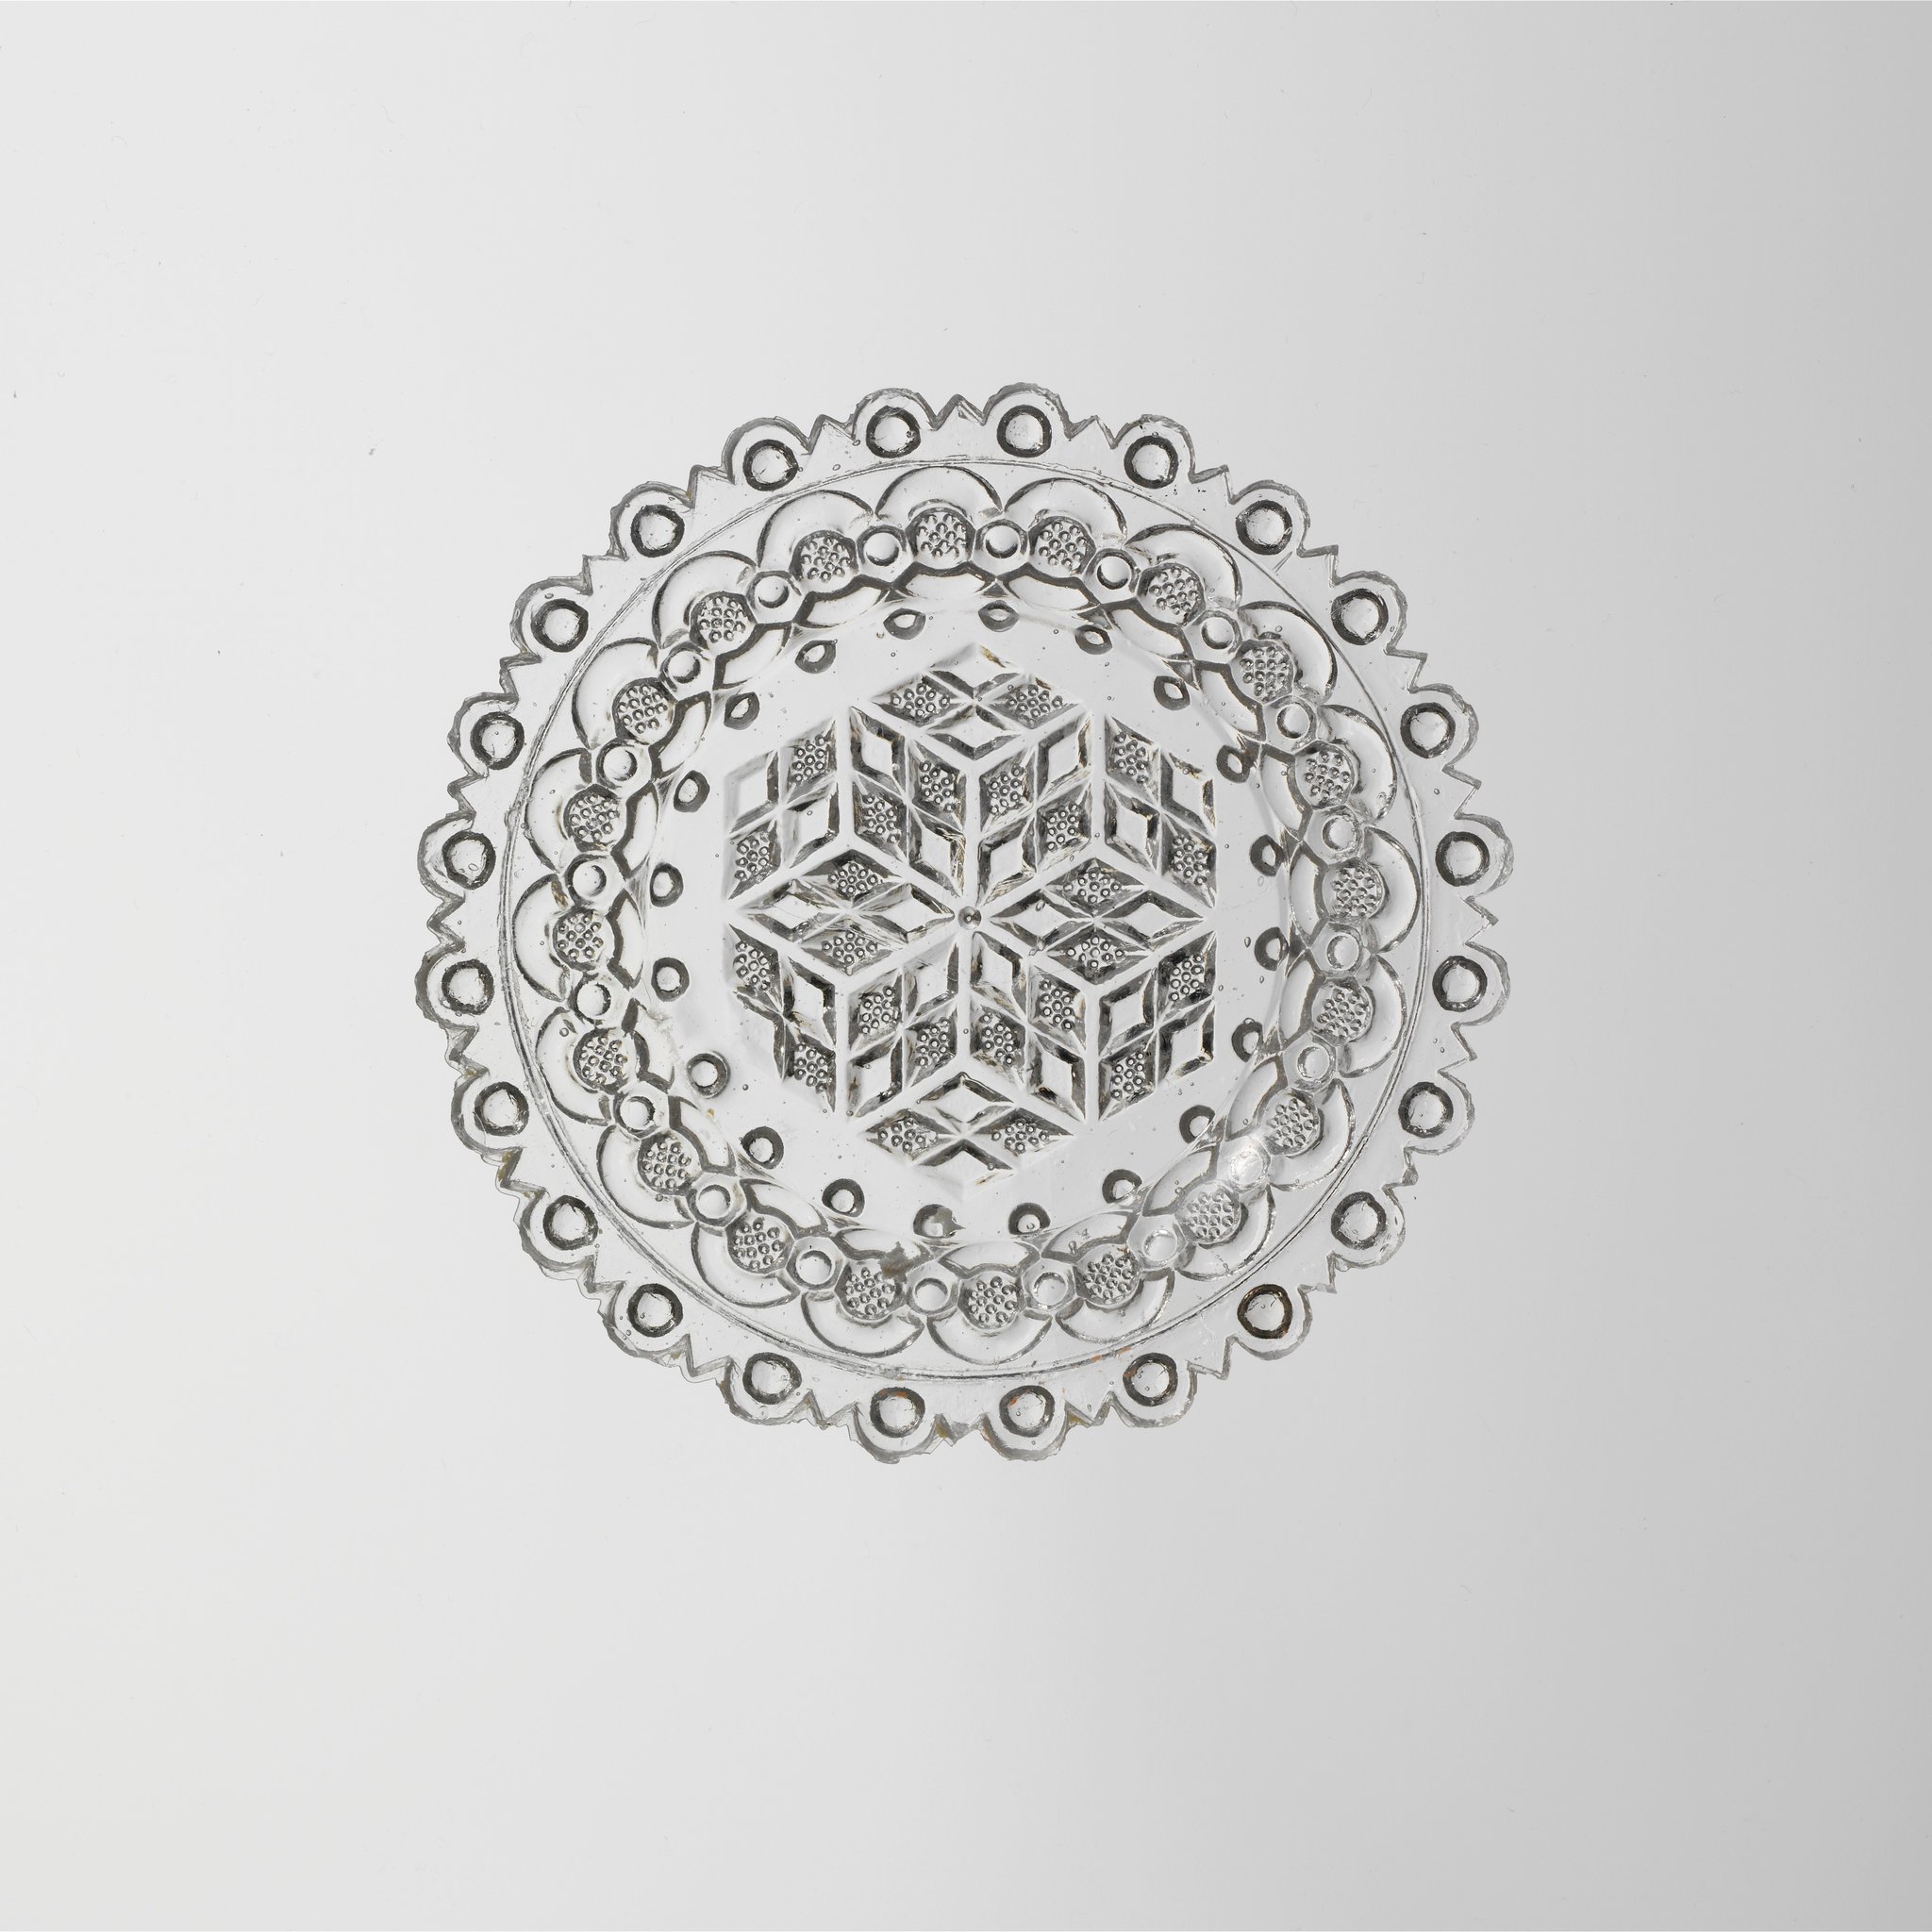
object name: cup plate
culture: american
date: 1825-1860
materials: glass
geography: united states